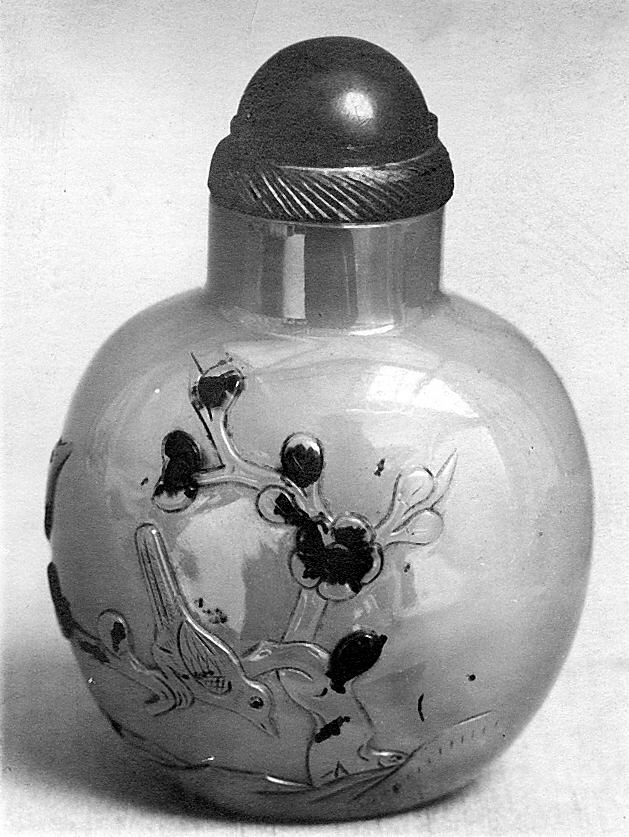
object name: snuff bottle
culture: chinese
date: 1801-1900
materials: stone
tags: birds